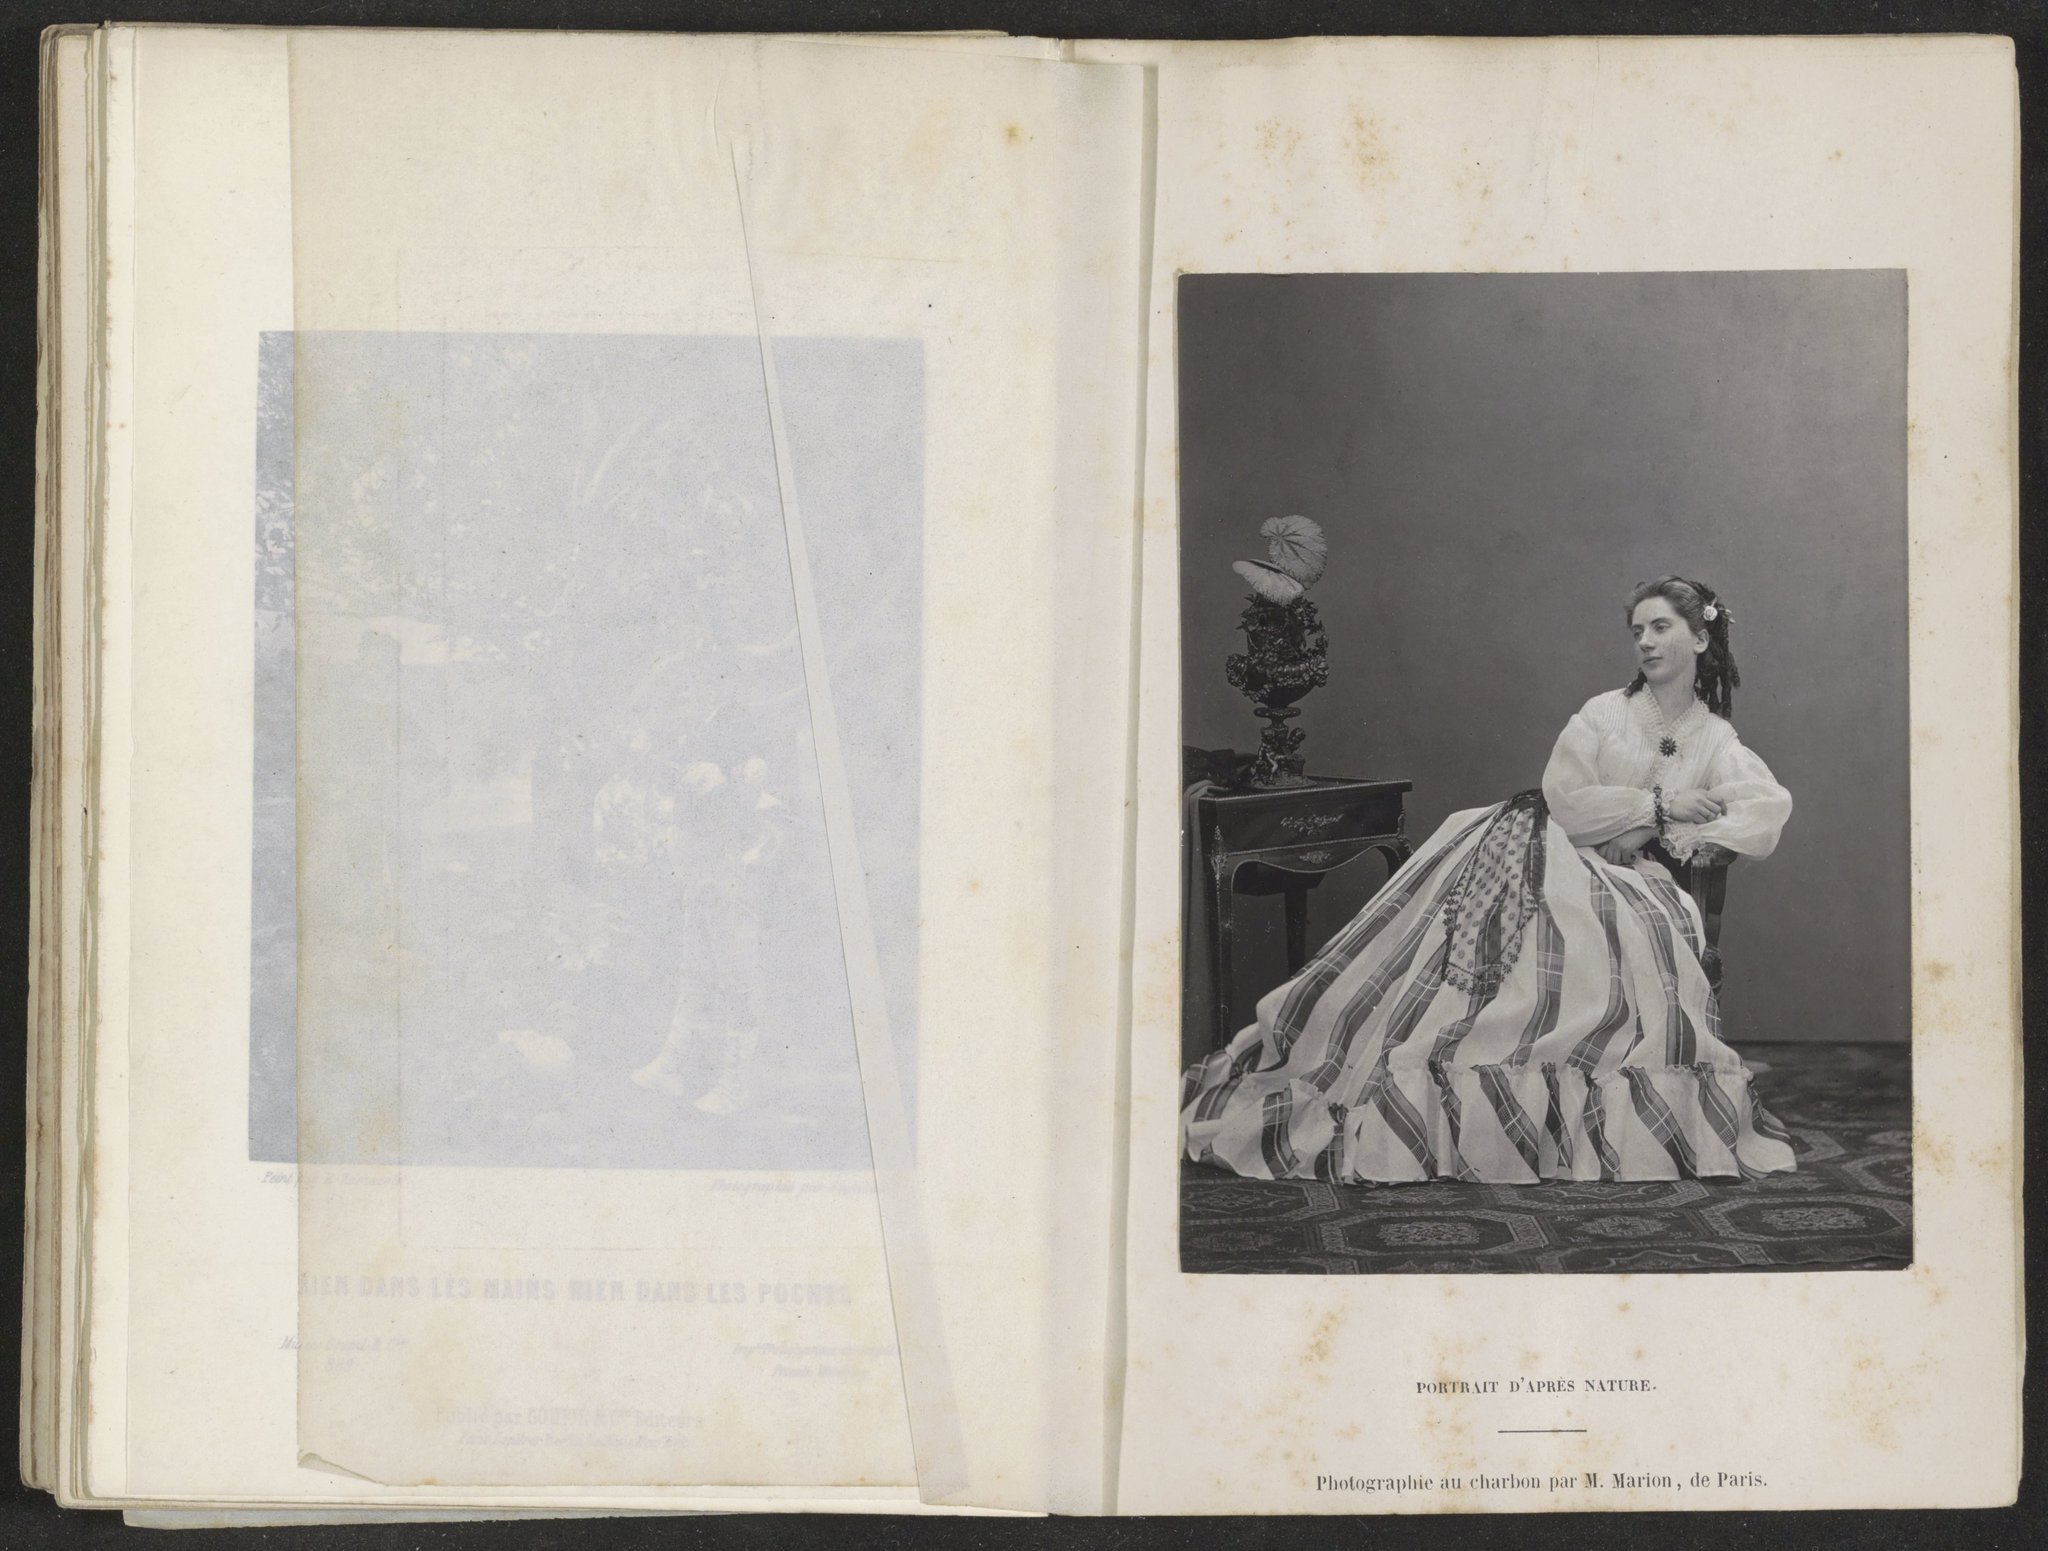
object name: photomechanical print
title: Portret van een onbekende vrouw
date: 1859-1869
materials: paper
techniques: carbon print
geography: france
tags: historical persons not known by name - bb - woman